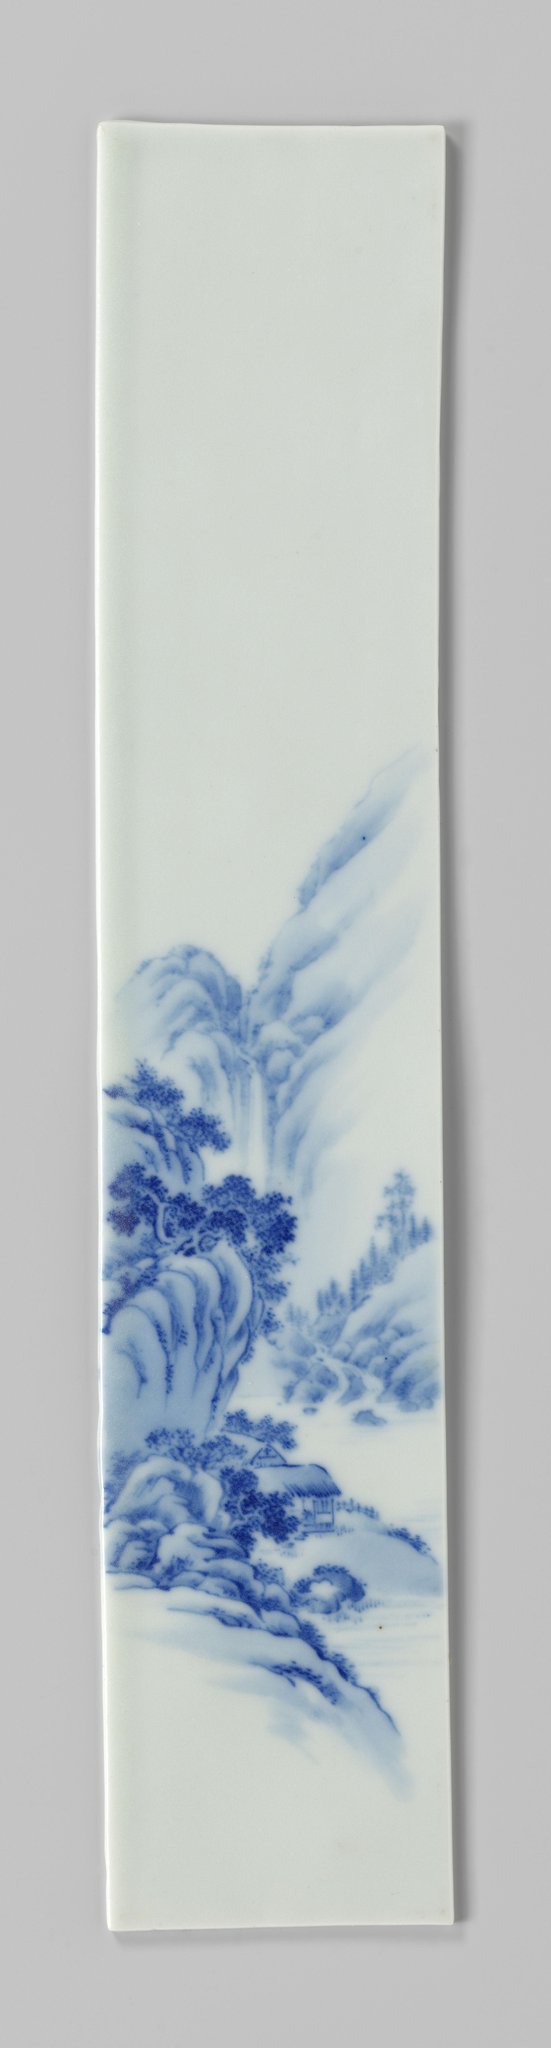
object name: plaque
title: Plaque with a water landscape with a pavilion, trees, mountains and a waterfall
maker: Anonymous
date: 1900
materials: cobalt, glaze, paint, porcelain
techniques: firing, vitrification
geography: japan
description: Rechthoekige plaque van porselein, beschilderd in onderglazuur blauw. Op de voorzijde een rivierlandschap met een paviljoen aan de oever omgeven door bomen, in de achtergrond een bergpartij met bomen en een waterval. Blauw-wit.